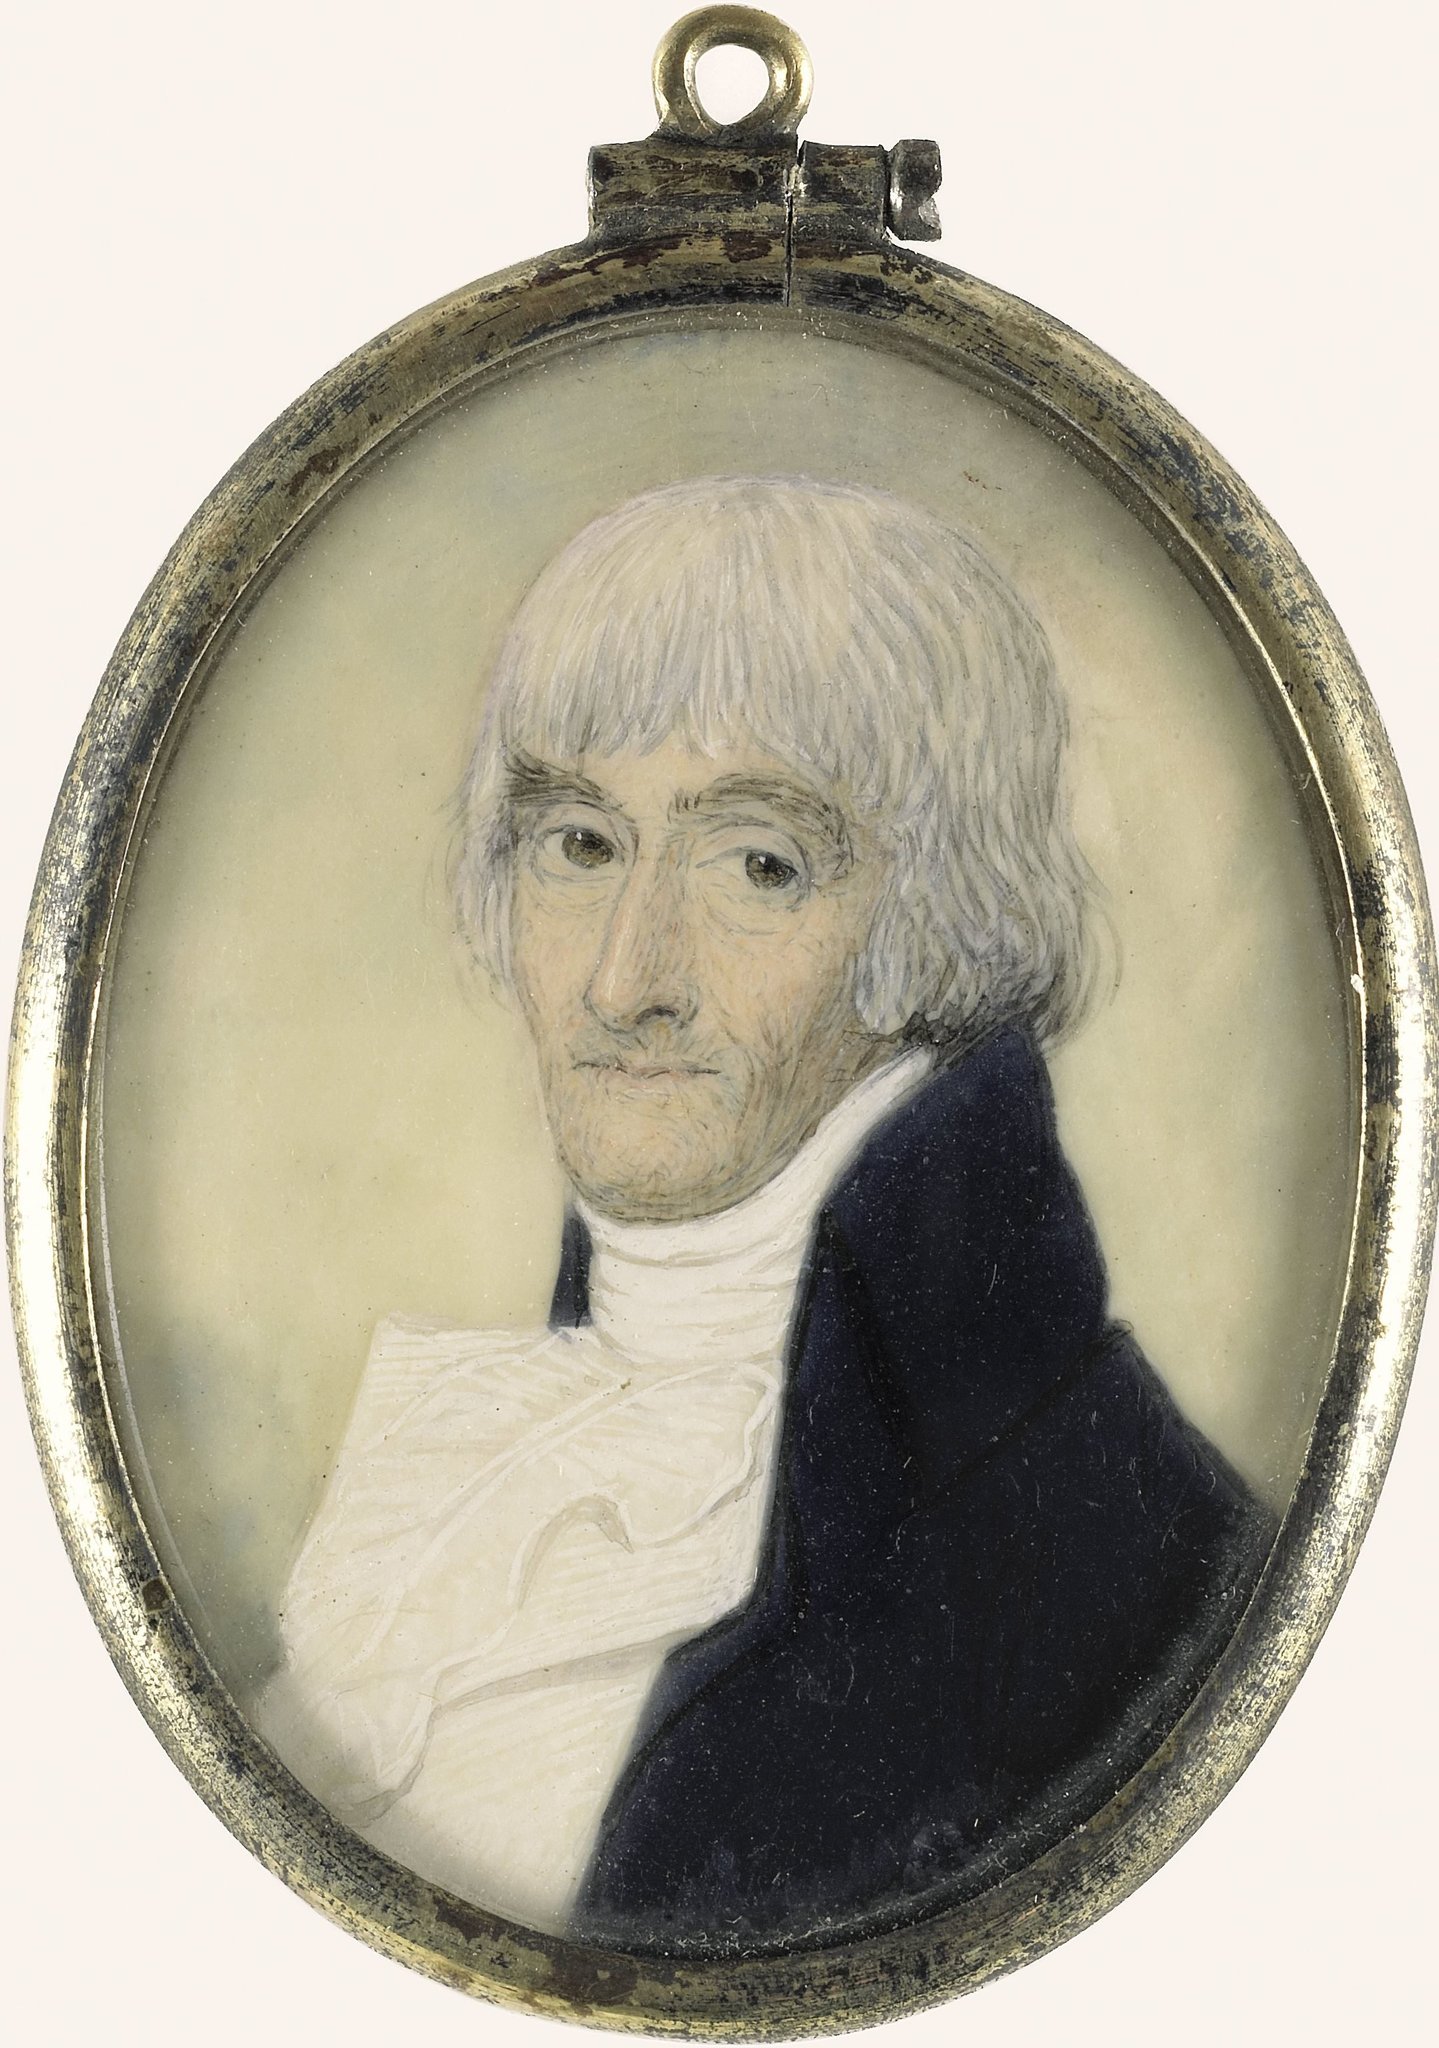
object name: painting, miniature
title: Portret van een man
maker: Anonymous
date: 1805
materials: glass, ivory, metal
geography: northern netherlands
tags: historical persons not known by name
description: Portret van een oudere man. Buste naar links, de beschouwer aanziend. Onderdeel van de collectie portretminiaturen.